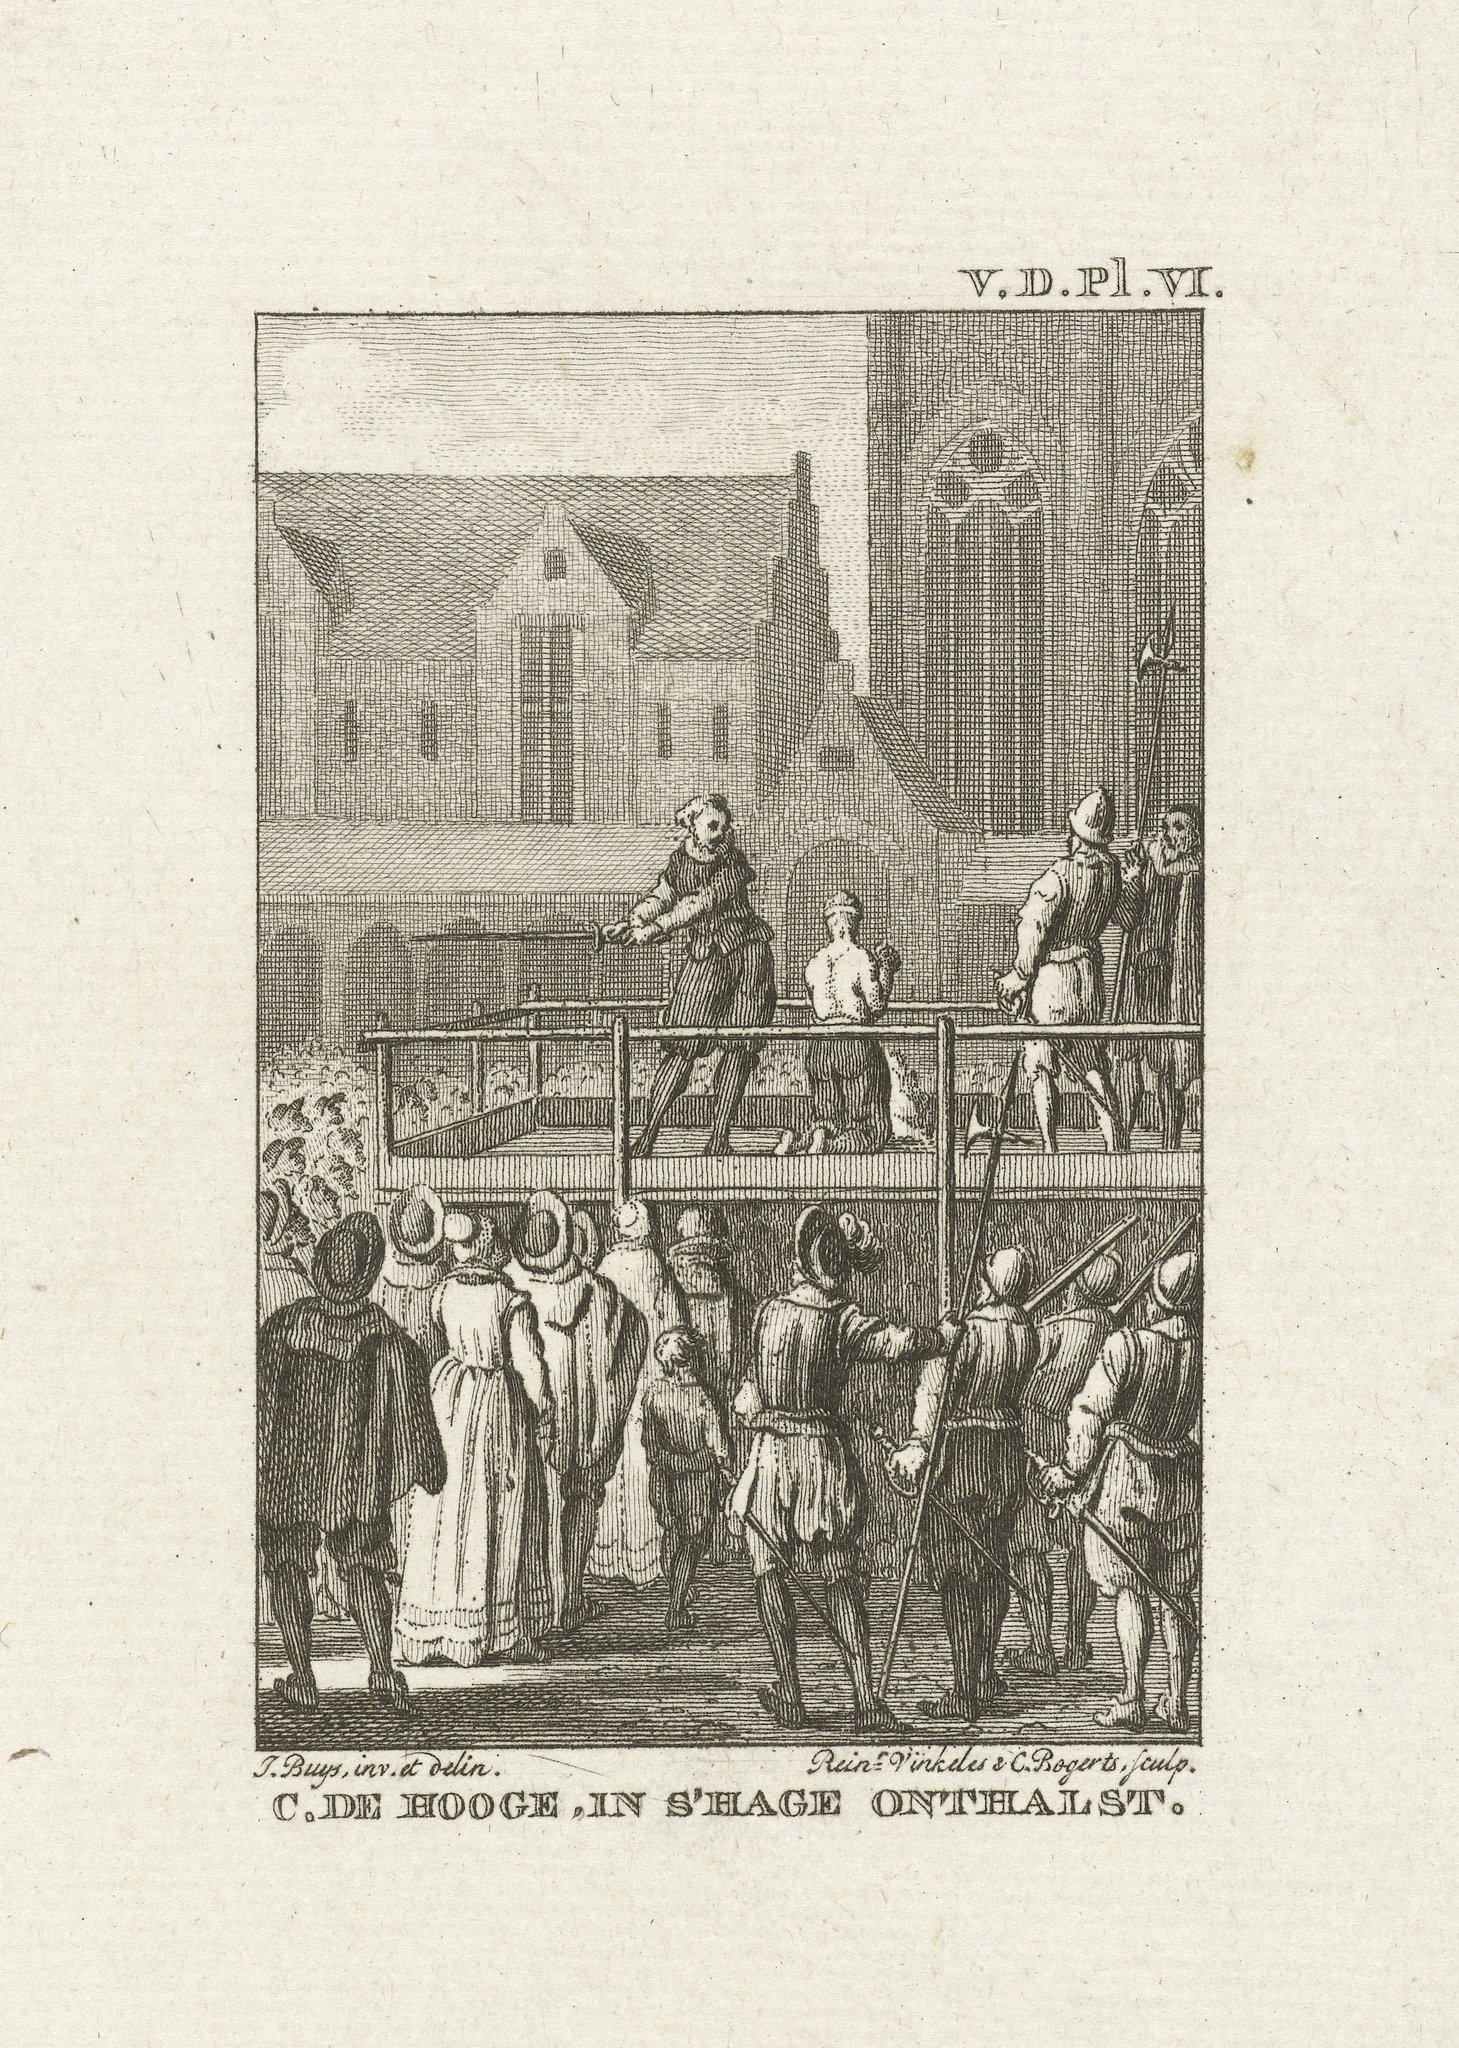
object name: print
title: Onthoofding van de graveur Cornelis de Hooghe, 1583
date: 1780-1795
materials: paper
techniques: etching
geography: netherlands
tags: the hague, print maker, cornelis de hooghe, on the scaffold or place of execution, violent death by beheading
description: Onthoofding van de Leidse graveur Cornelis de Hooghe, 29 maart 1583. De man knielt met ontbloot bovenlichaam voor de beul op het schavot. De Hooghe werd veroordeeld wegens landverraad en onthoofd en gevierendeeld.